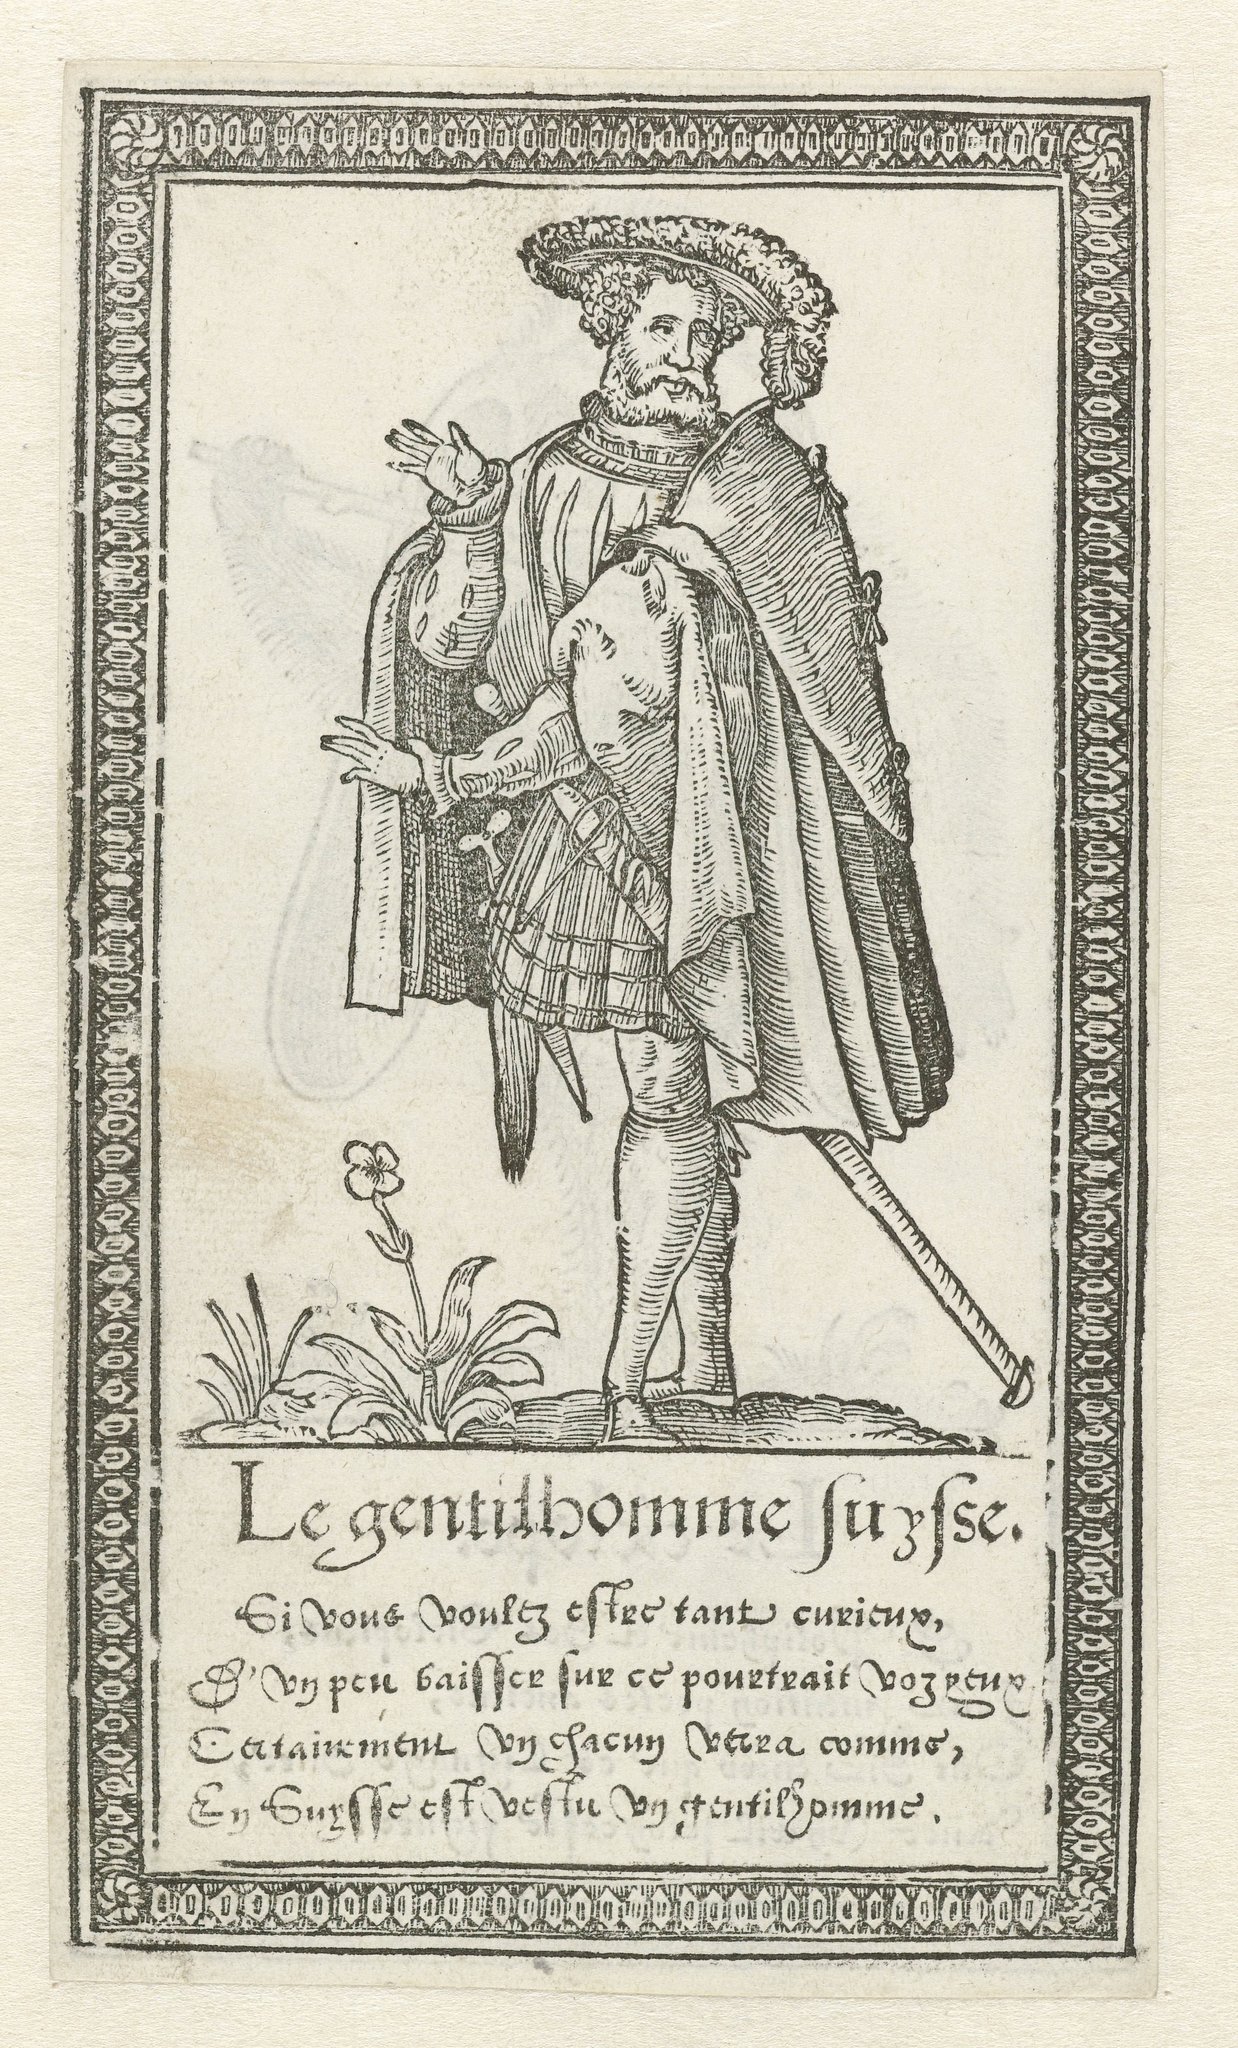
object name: print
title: Le gentilhomme suisse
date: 1562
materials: paper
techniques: woodcut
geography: paris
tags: fashion plates, europeans (swiss) (+ costume), folk costume, regional costume, nobility and patriciate; chivalry, knighthood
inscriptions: collector's mark: Lugt 2228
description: Dit is prent 54 uit een serie van 121. Binnen deze serie zijn er prenten gemaakt naar voorbeelden van Jean-François de Roberval en Enea Vico, onbekend welke precies.